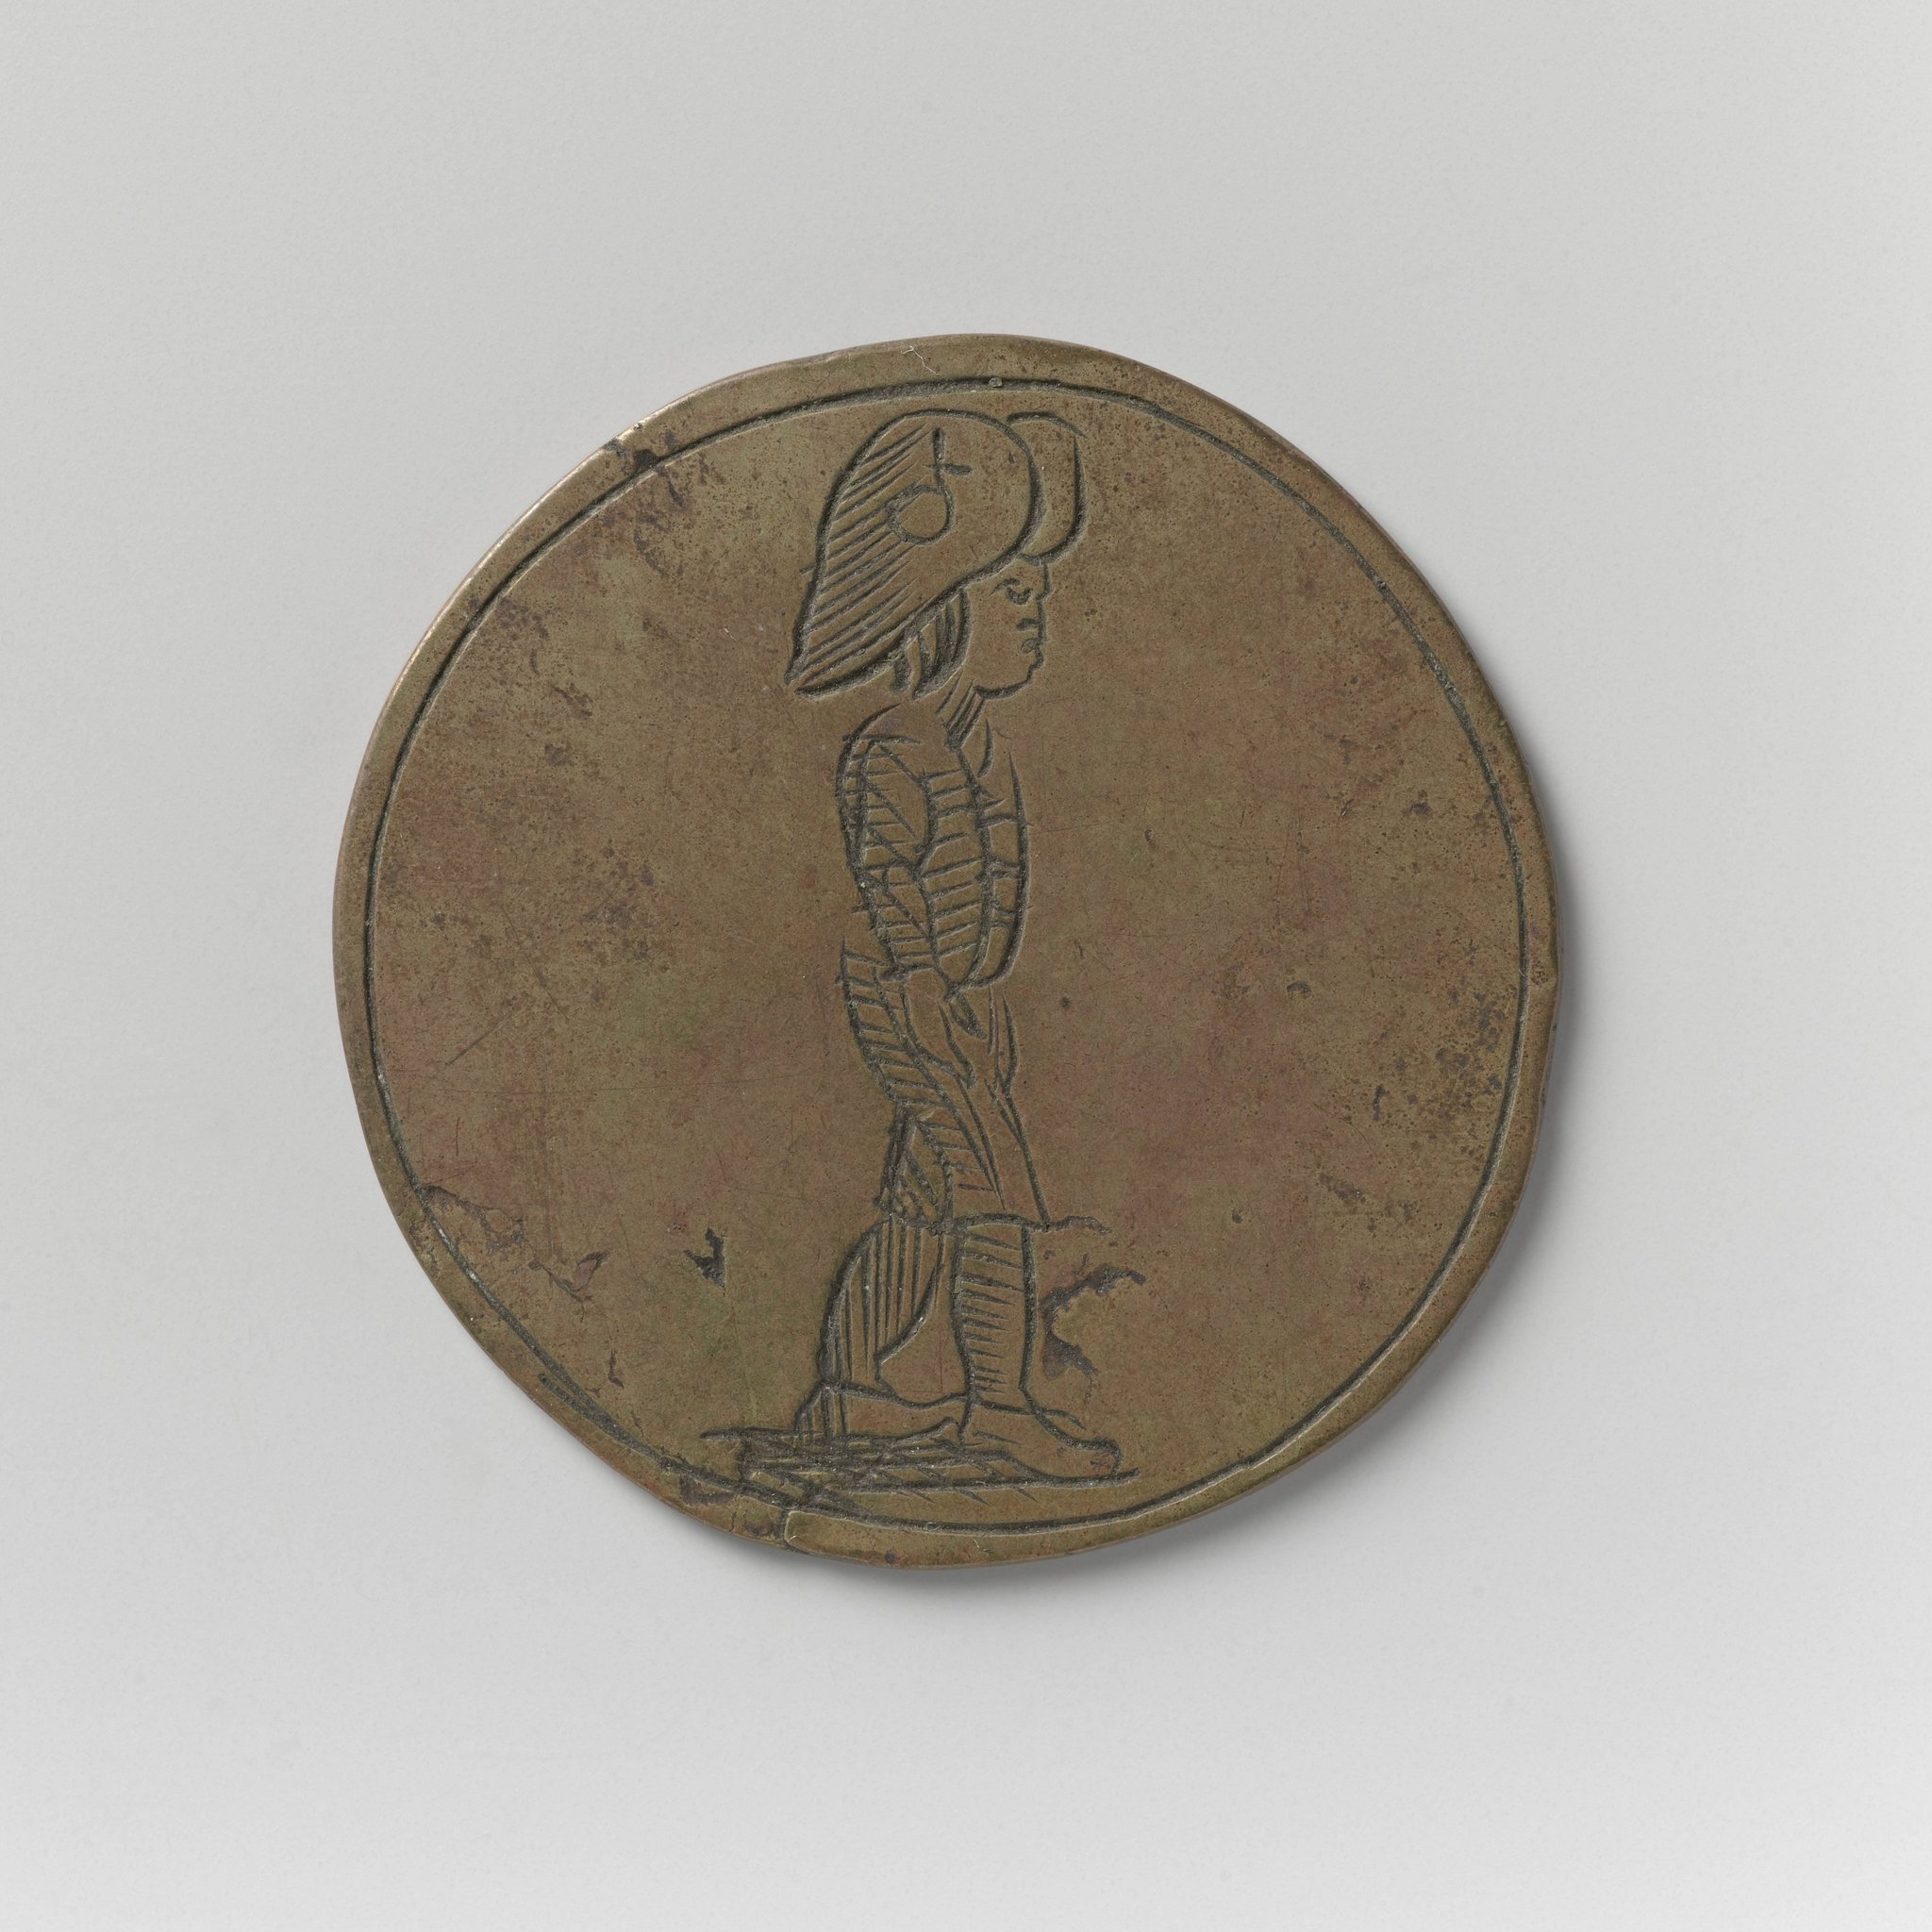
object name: medal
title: Korendragers- en -stortersgilde van Amsterdam, gildepenning van Wybrant Blom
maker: Anonymous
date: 1766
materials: copper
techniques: engraving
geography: amsterdam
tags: amsterdam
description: Koperen penning. Voorzijde: naar rechts gewende man met last op hoofd. Keerzijde: opschrift